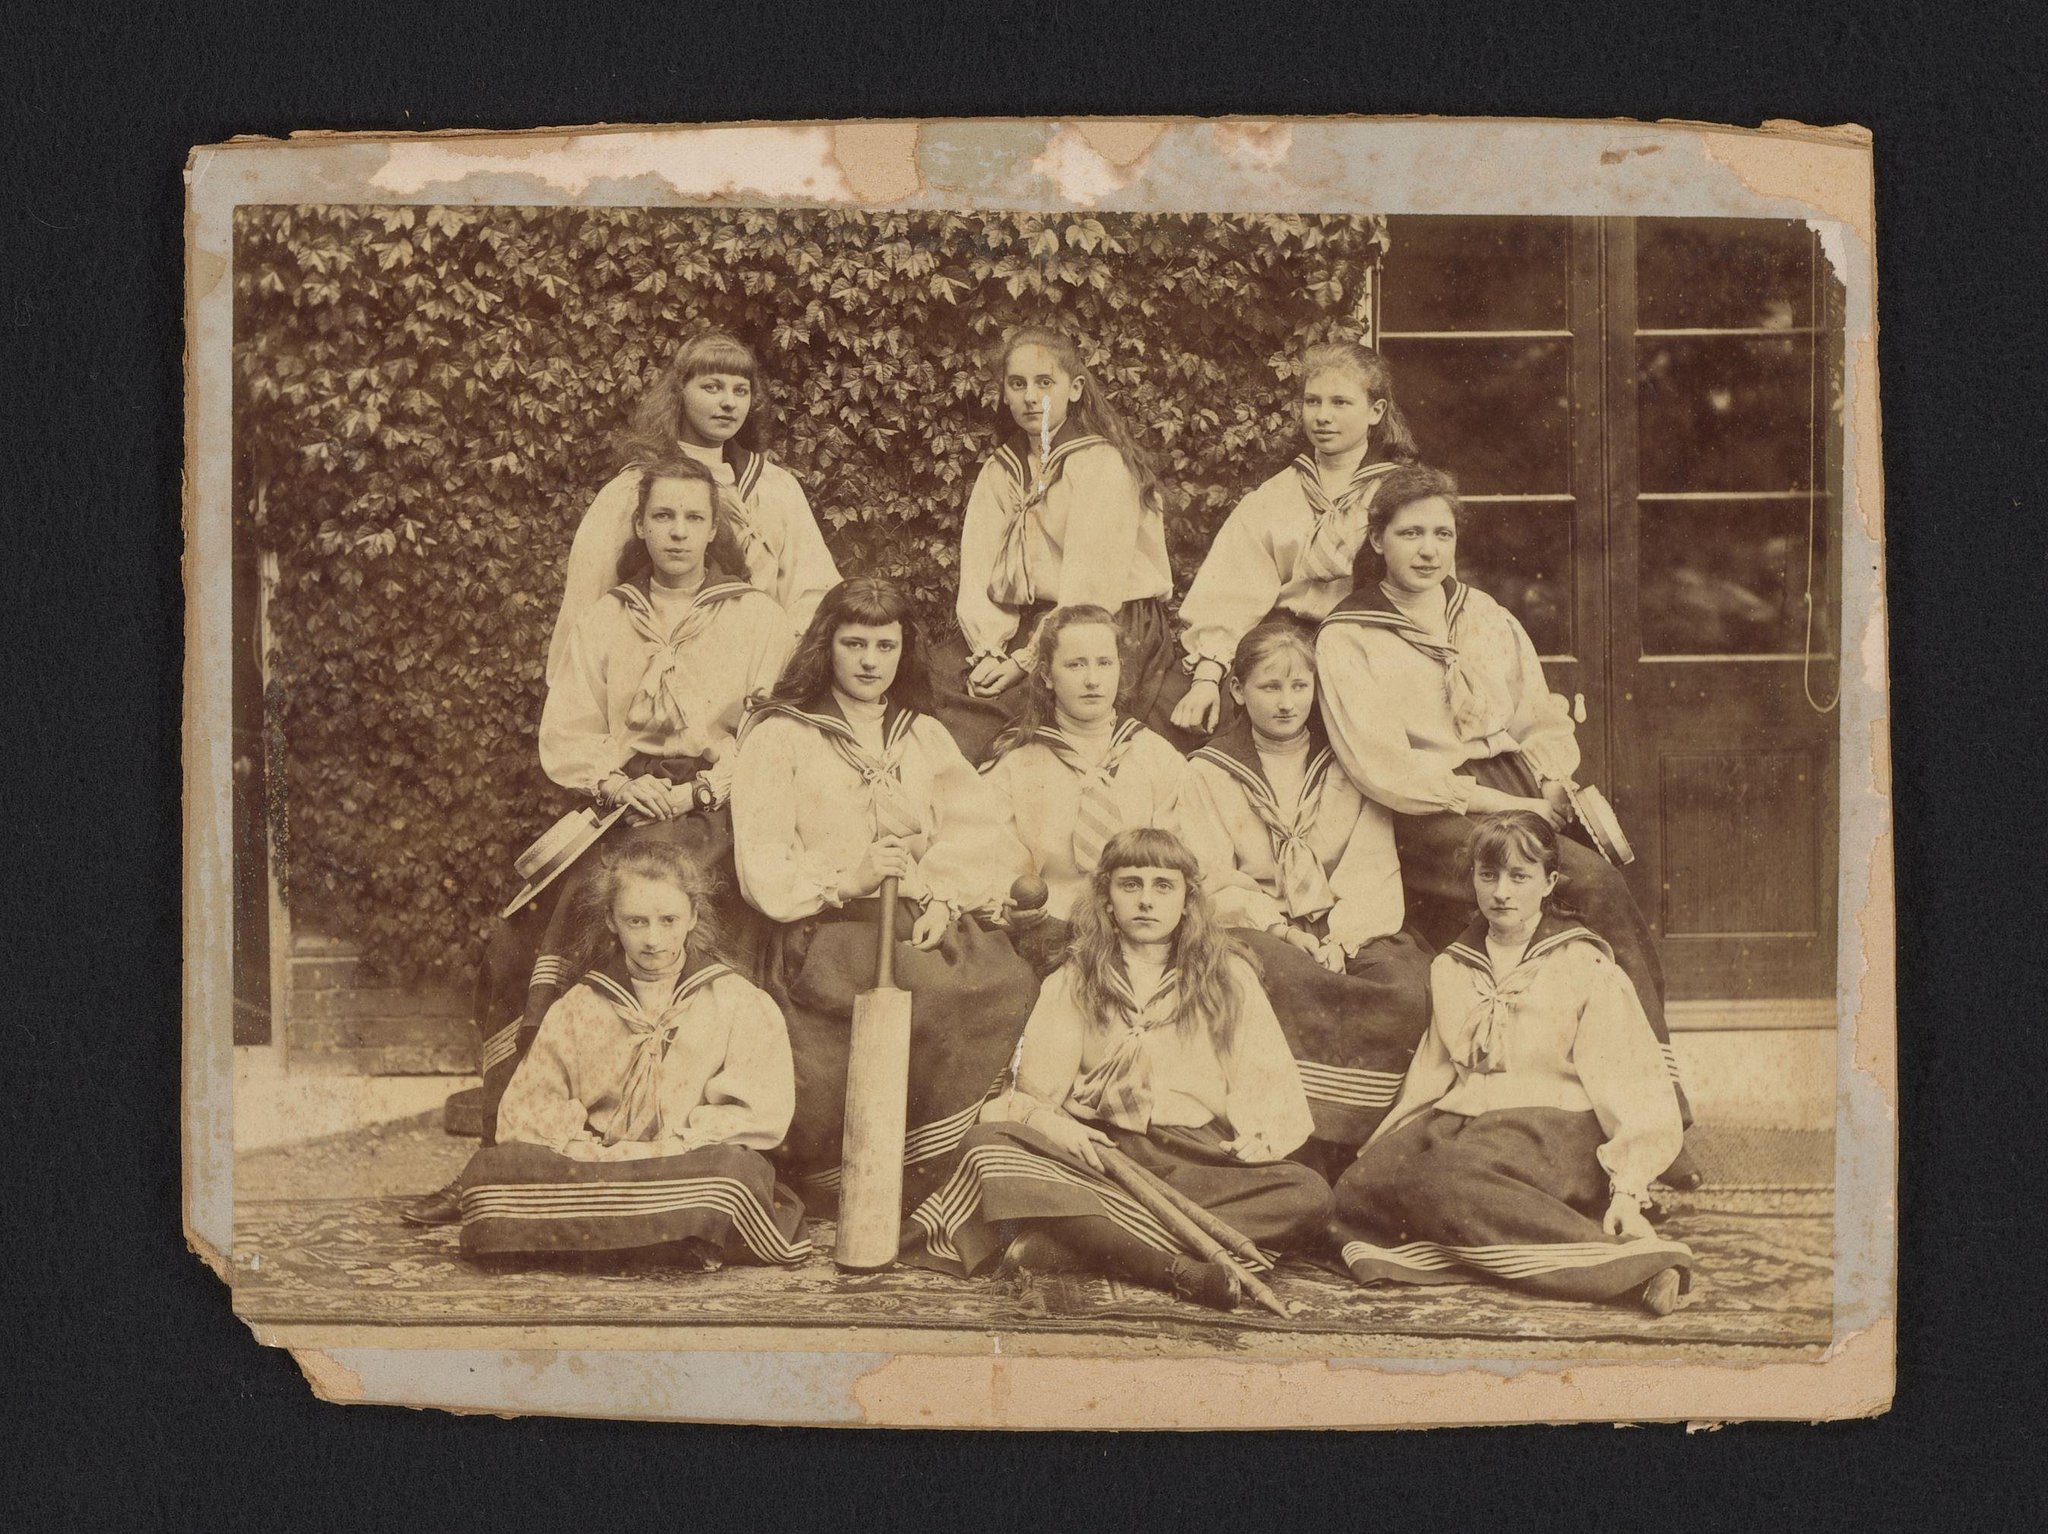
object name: photograph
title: Groepsportret met meisjes uit het cricket team van de Halliwick School for Girls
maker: Anonymous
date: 1890-1900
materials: cardboard, photographic support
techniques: albumen print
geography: london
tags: adolescent, young woman, maiden, anonymous historical persons portrayed in a group, in a group-portrait - bb - woman, cricket (ball game)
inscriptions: annotation: ‘[...]’